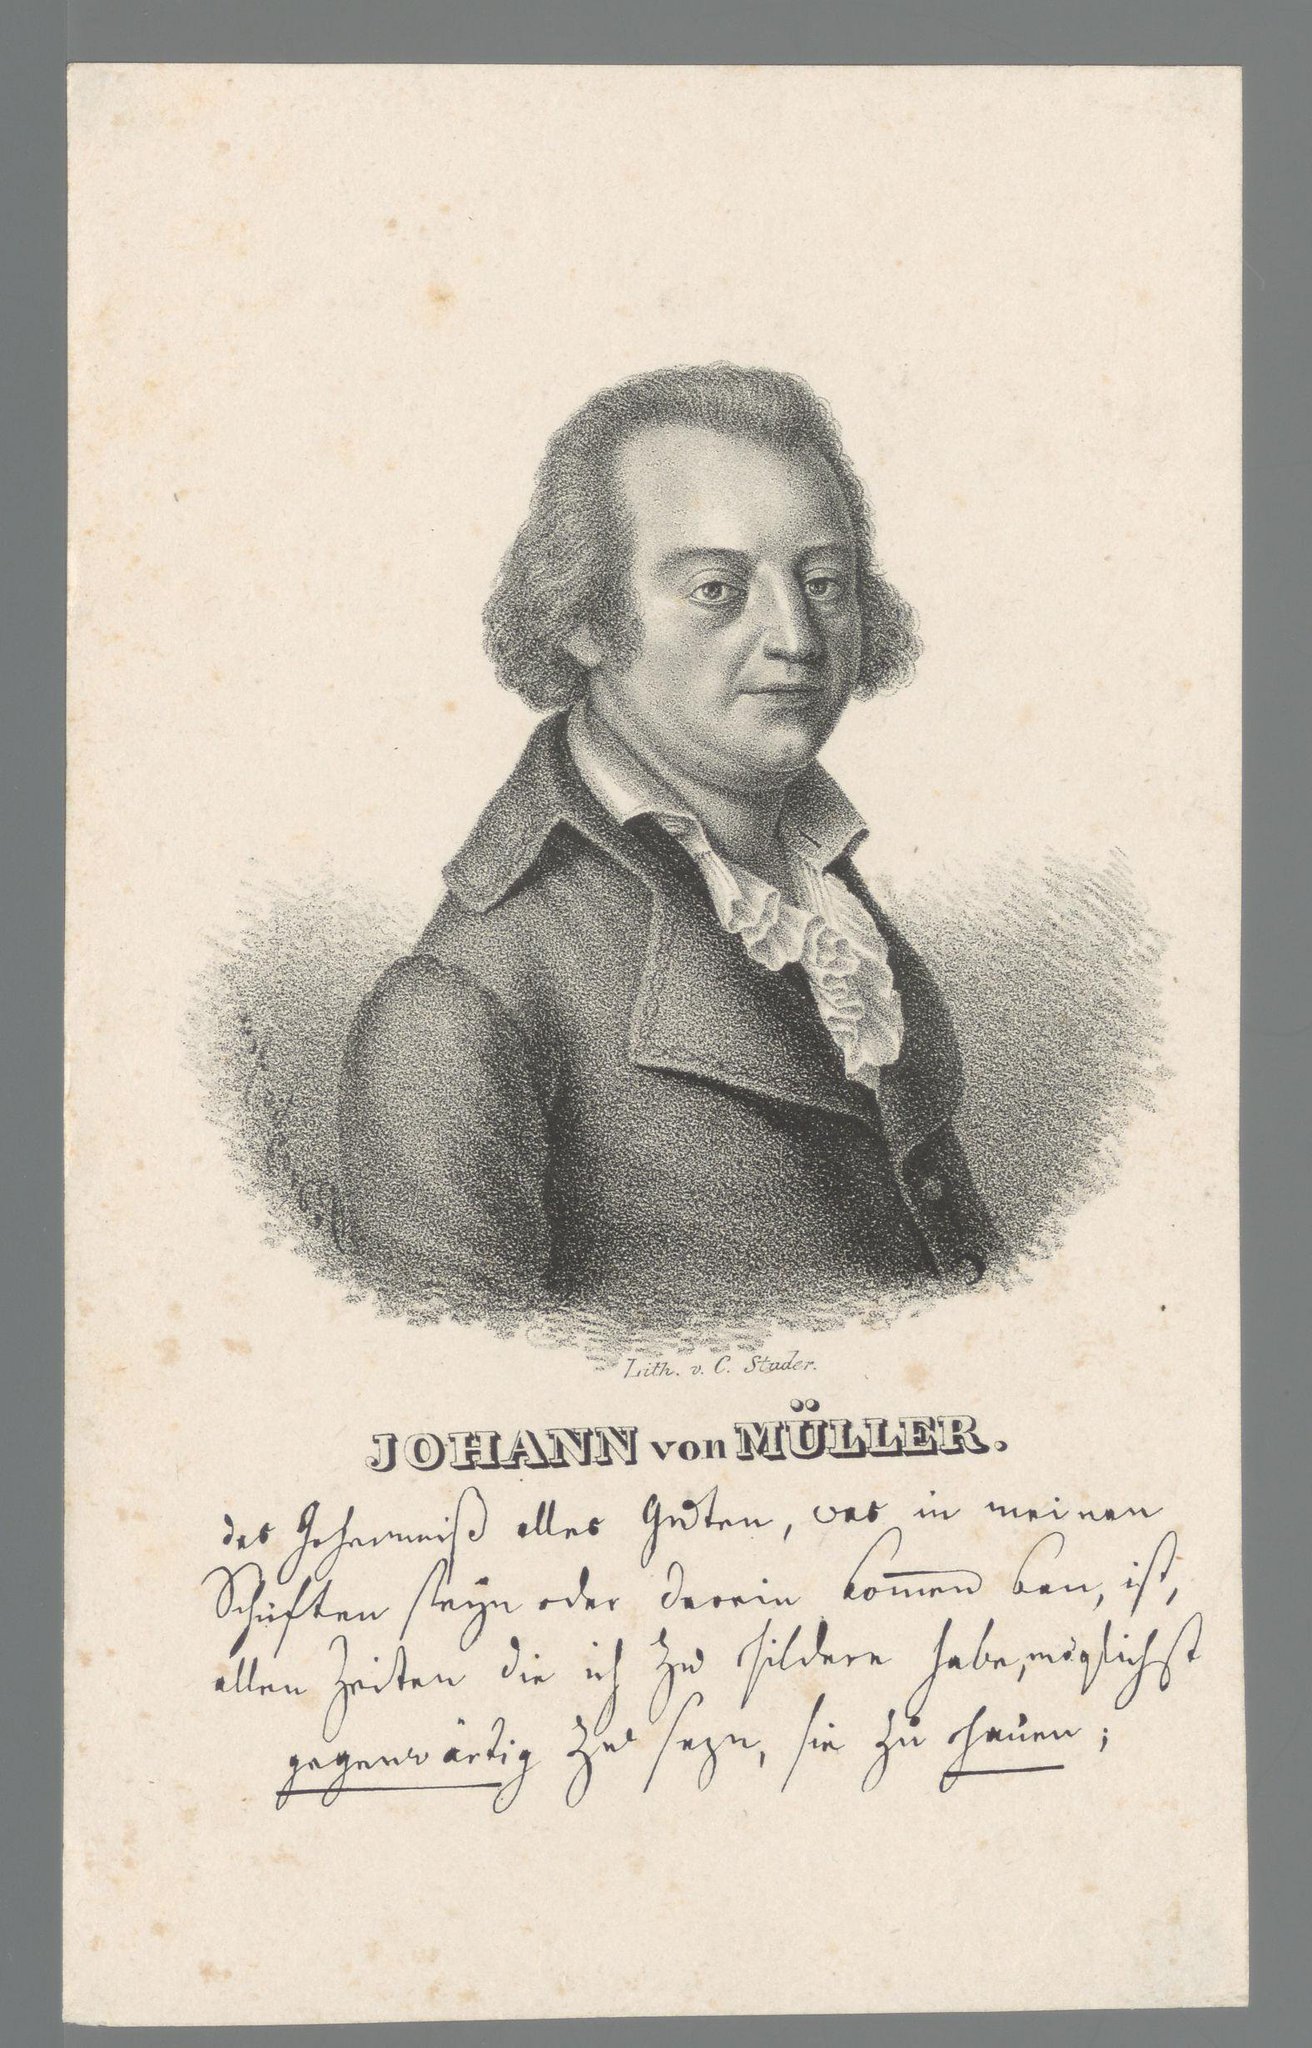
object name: print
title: Johann von Müller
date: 1820-1850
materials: paper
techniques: lithograph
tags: adult man, historical persons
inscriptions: collector's mark: Lugt 2228